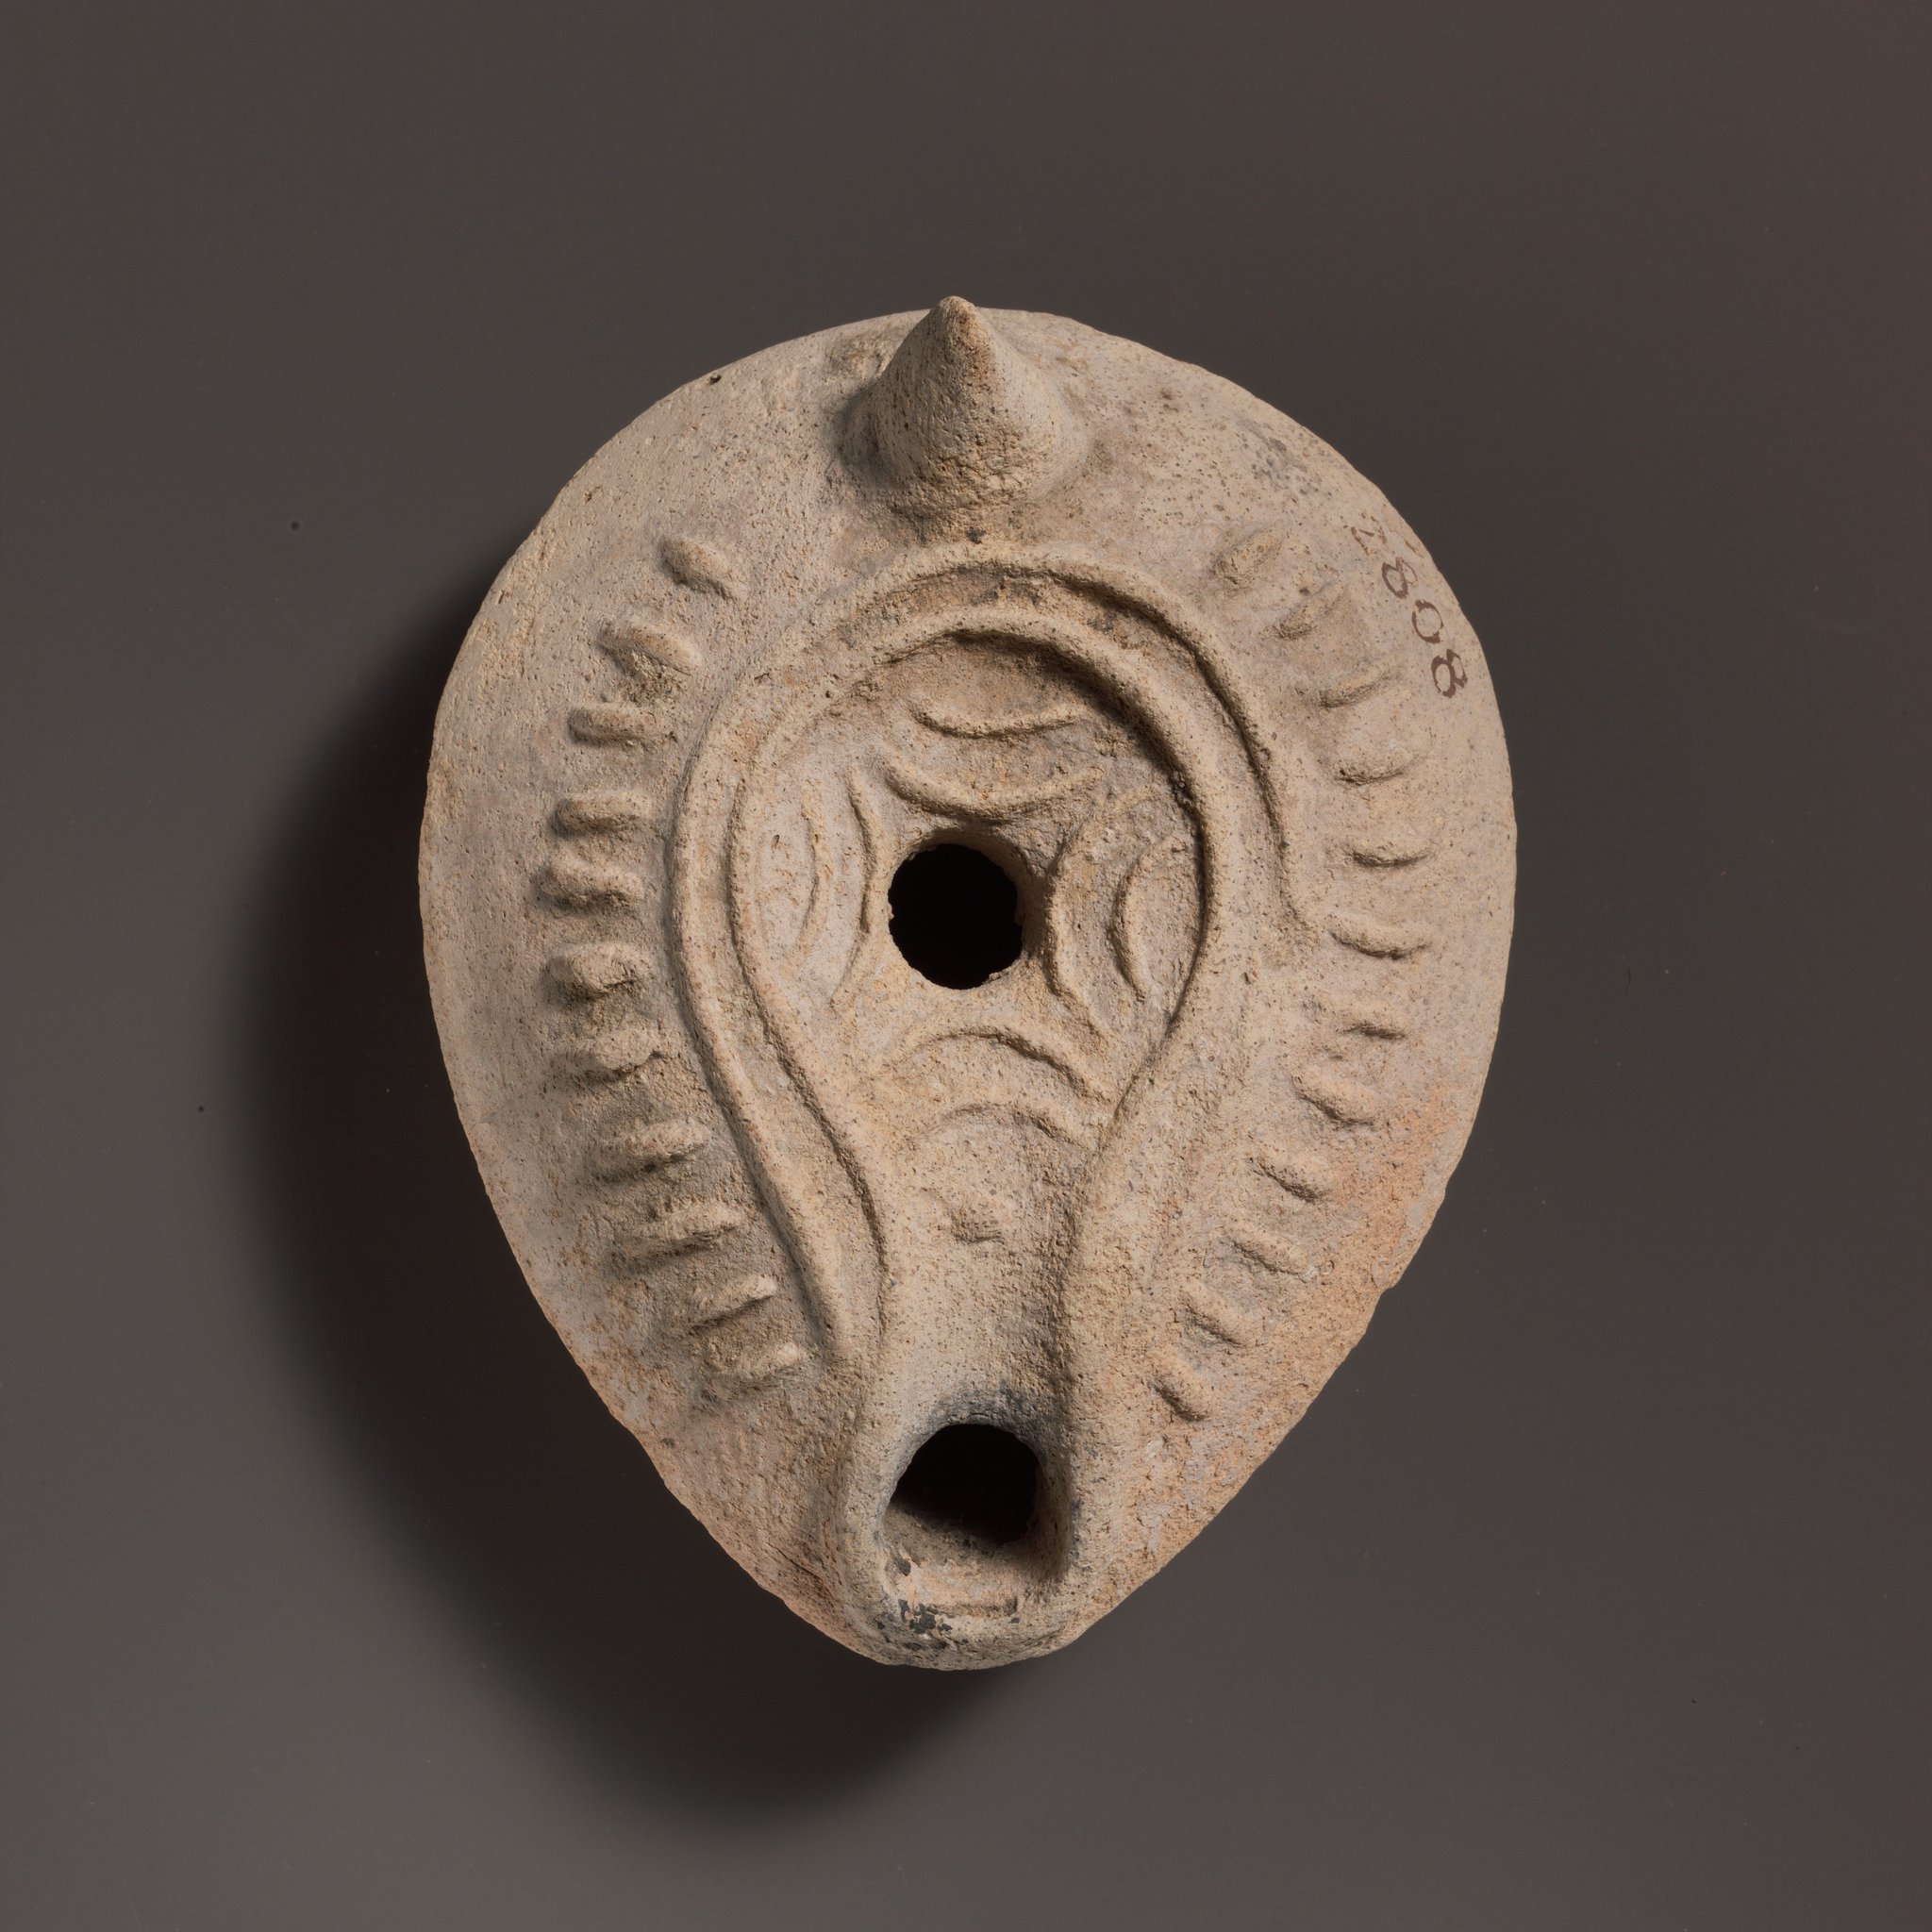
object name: lamp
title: Terracotta oil lamp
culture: roman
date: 601-700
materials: terracotta